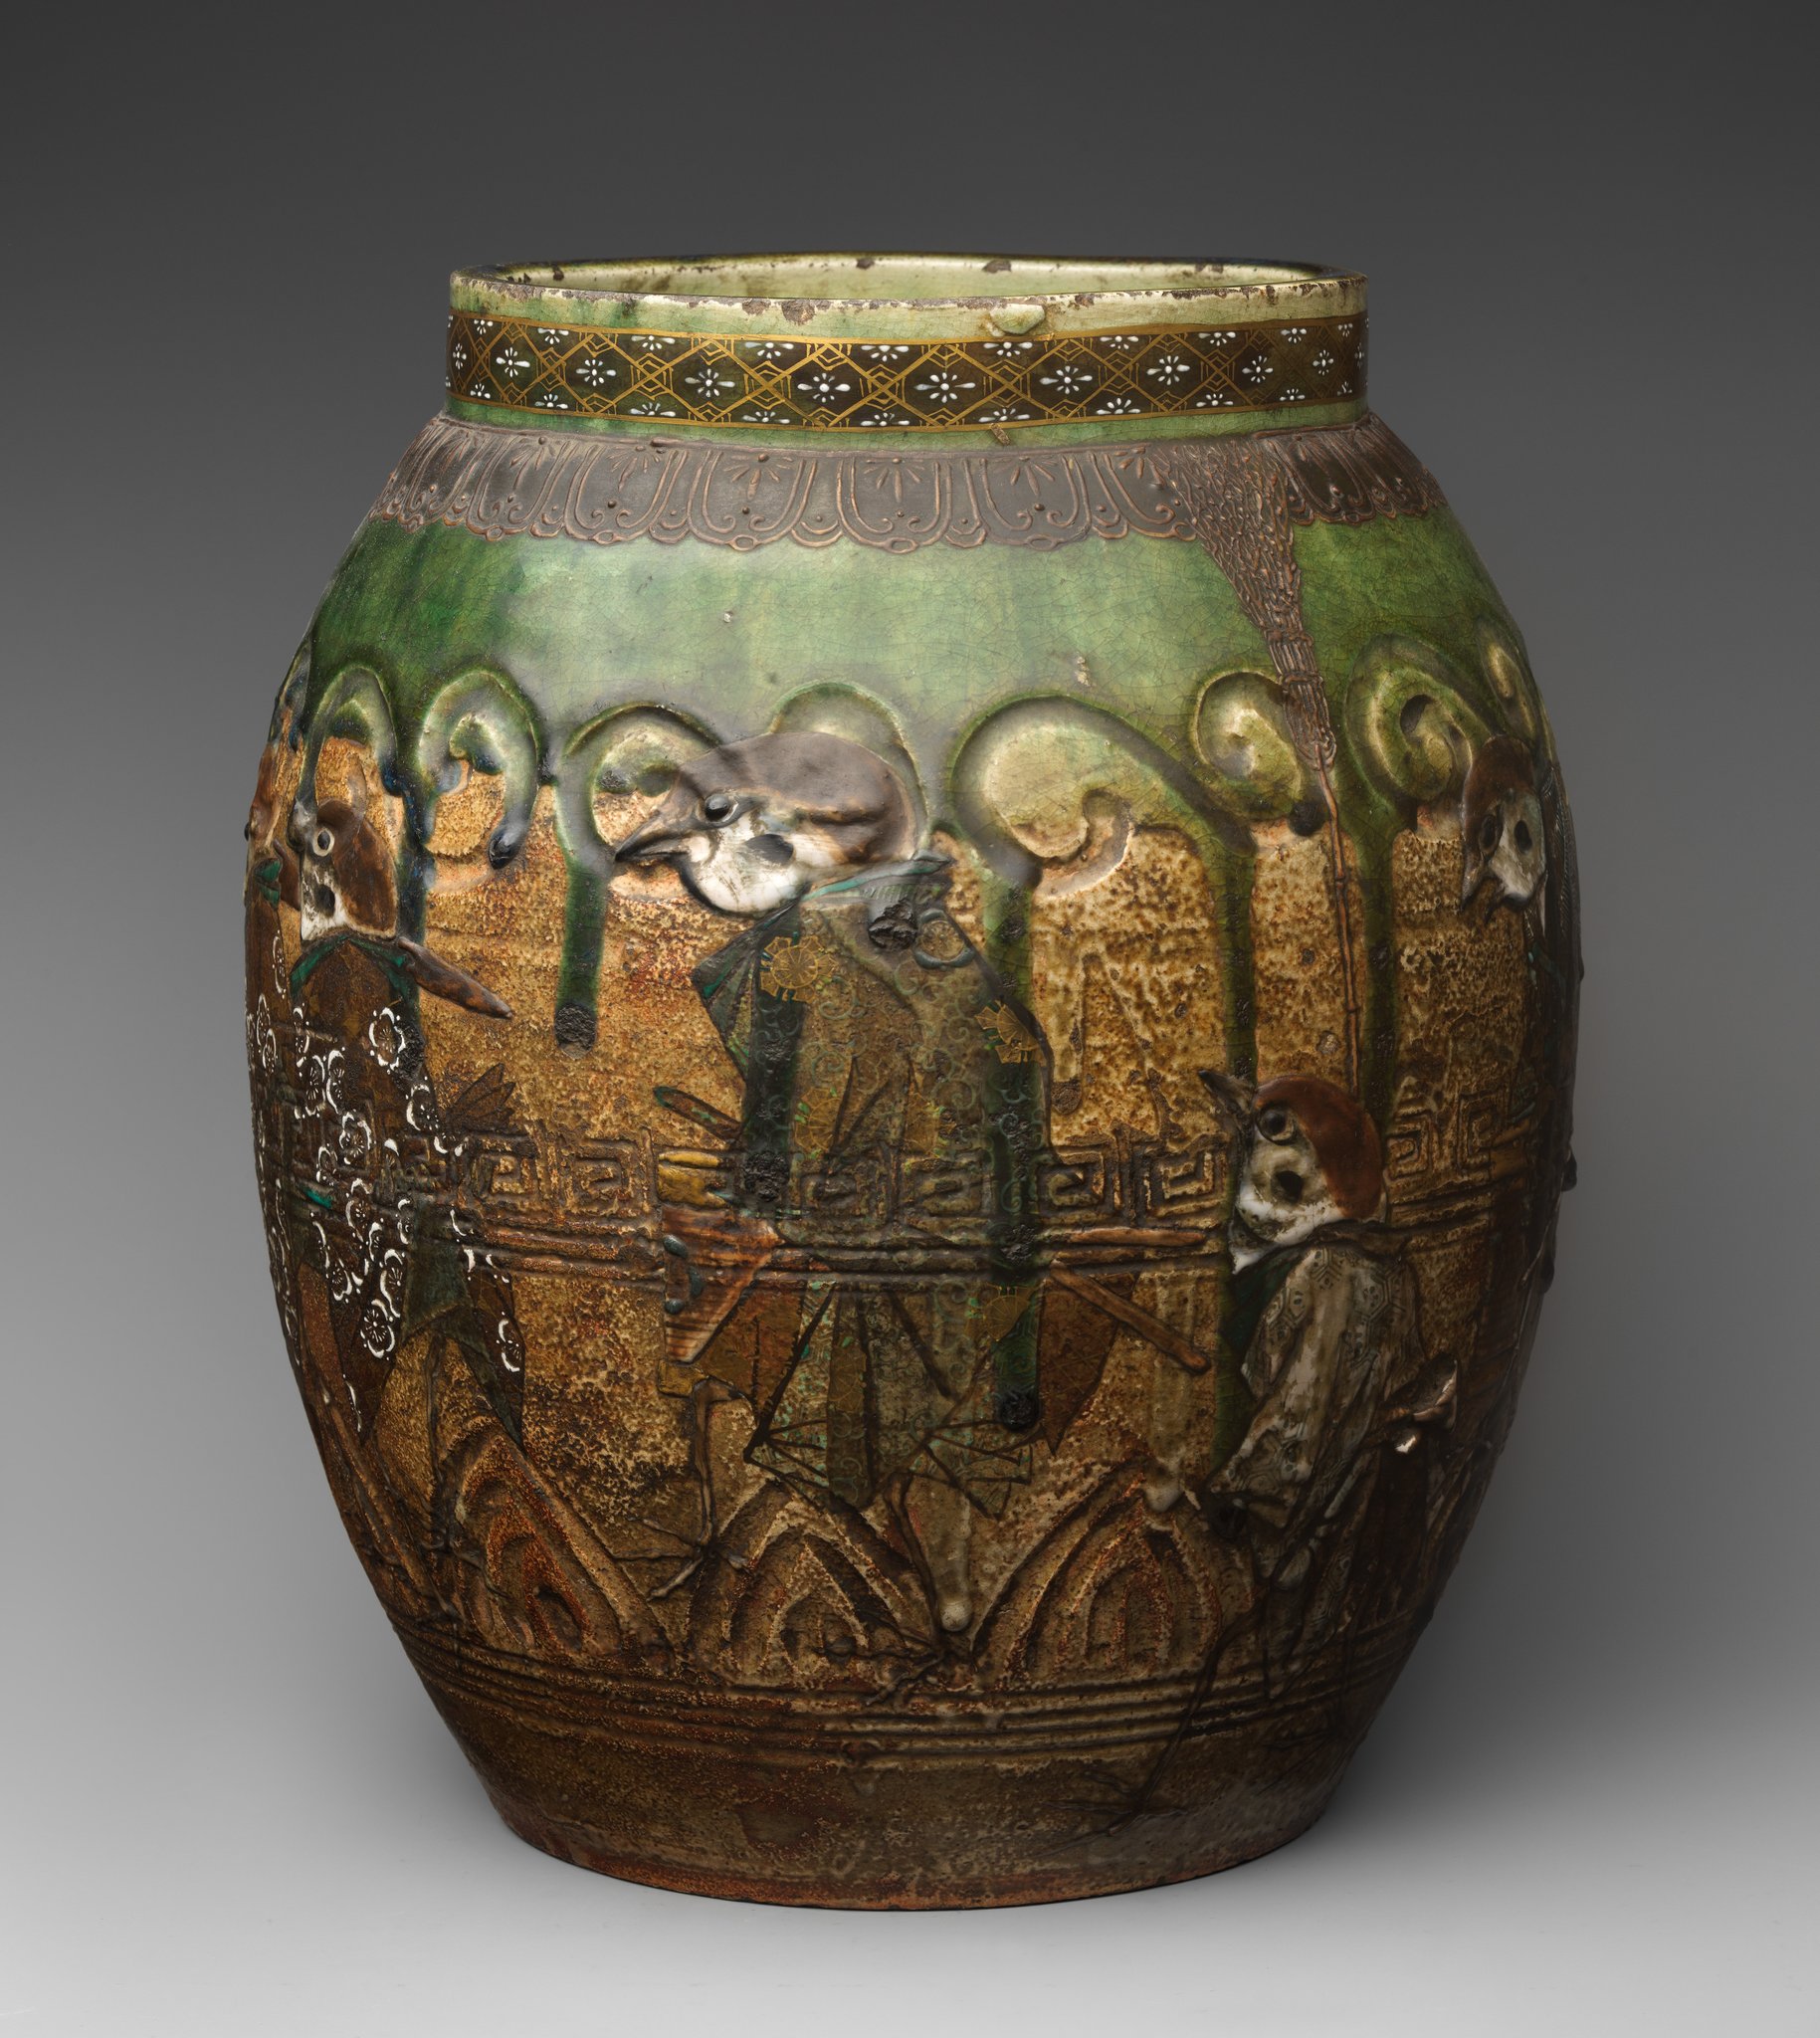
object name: jar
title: Large Pear-Shaped Jar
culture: japanese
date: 1701-1900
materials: enamel, pottery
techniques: polychrome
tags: birds